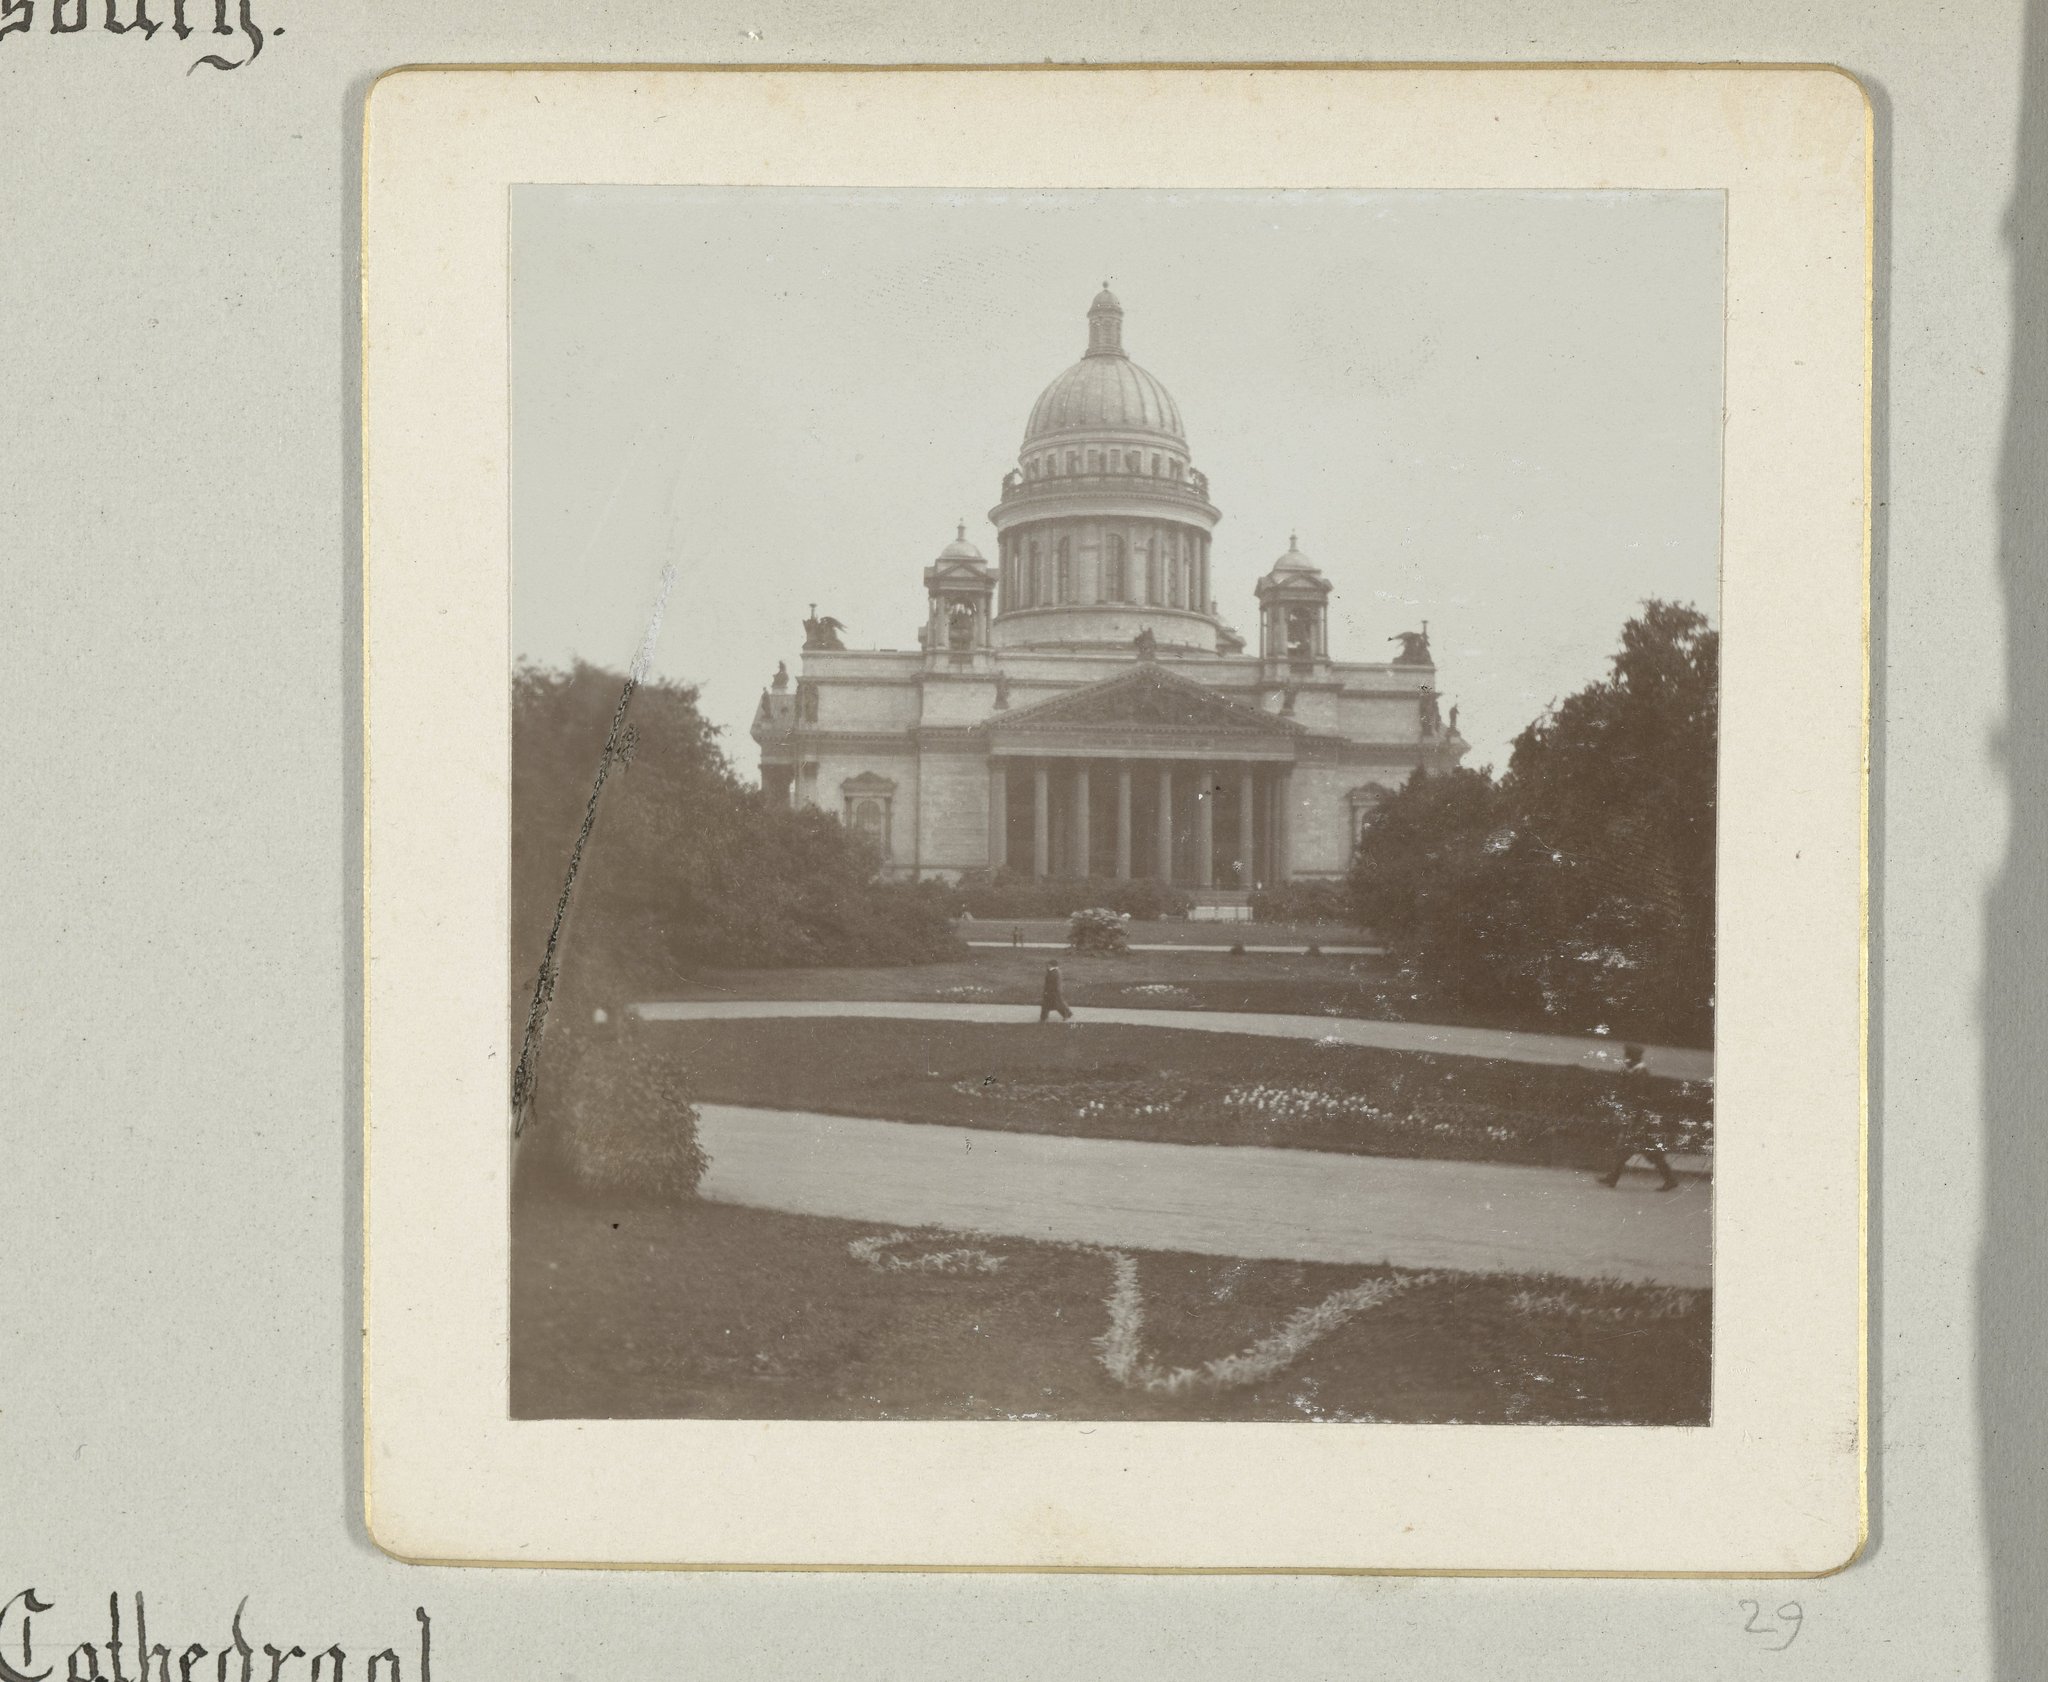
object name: photograph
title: Voorkant van de Sint Isaac Kathedraal in Sint-Petersburg, ontworpen door Auguste Montferrand.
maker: henry pauw van wieldrecht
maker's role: fotograaf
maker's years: 1863-1912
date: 1898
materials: paper, photographic support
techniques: albumen print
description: Sint Isaac Kathedraal, ontworpen door Auguste Montferrand, tegenwoordig een museum.